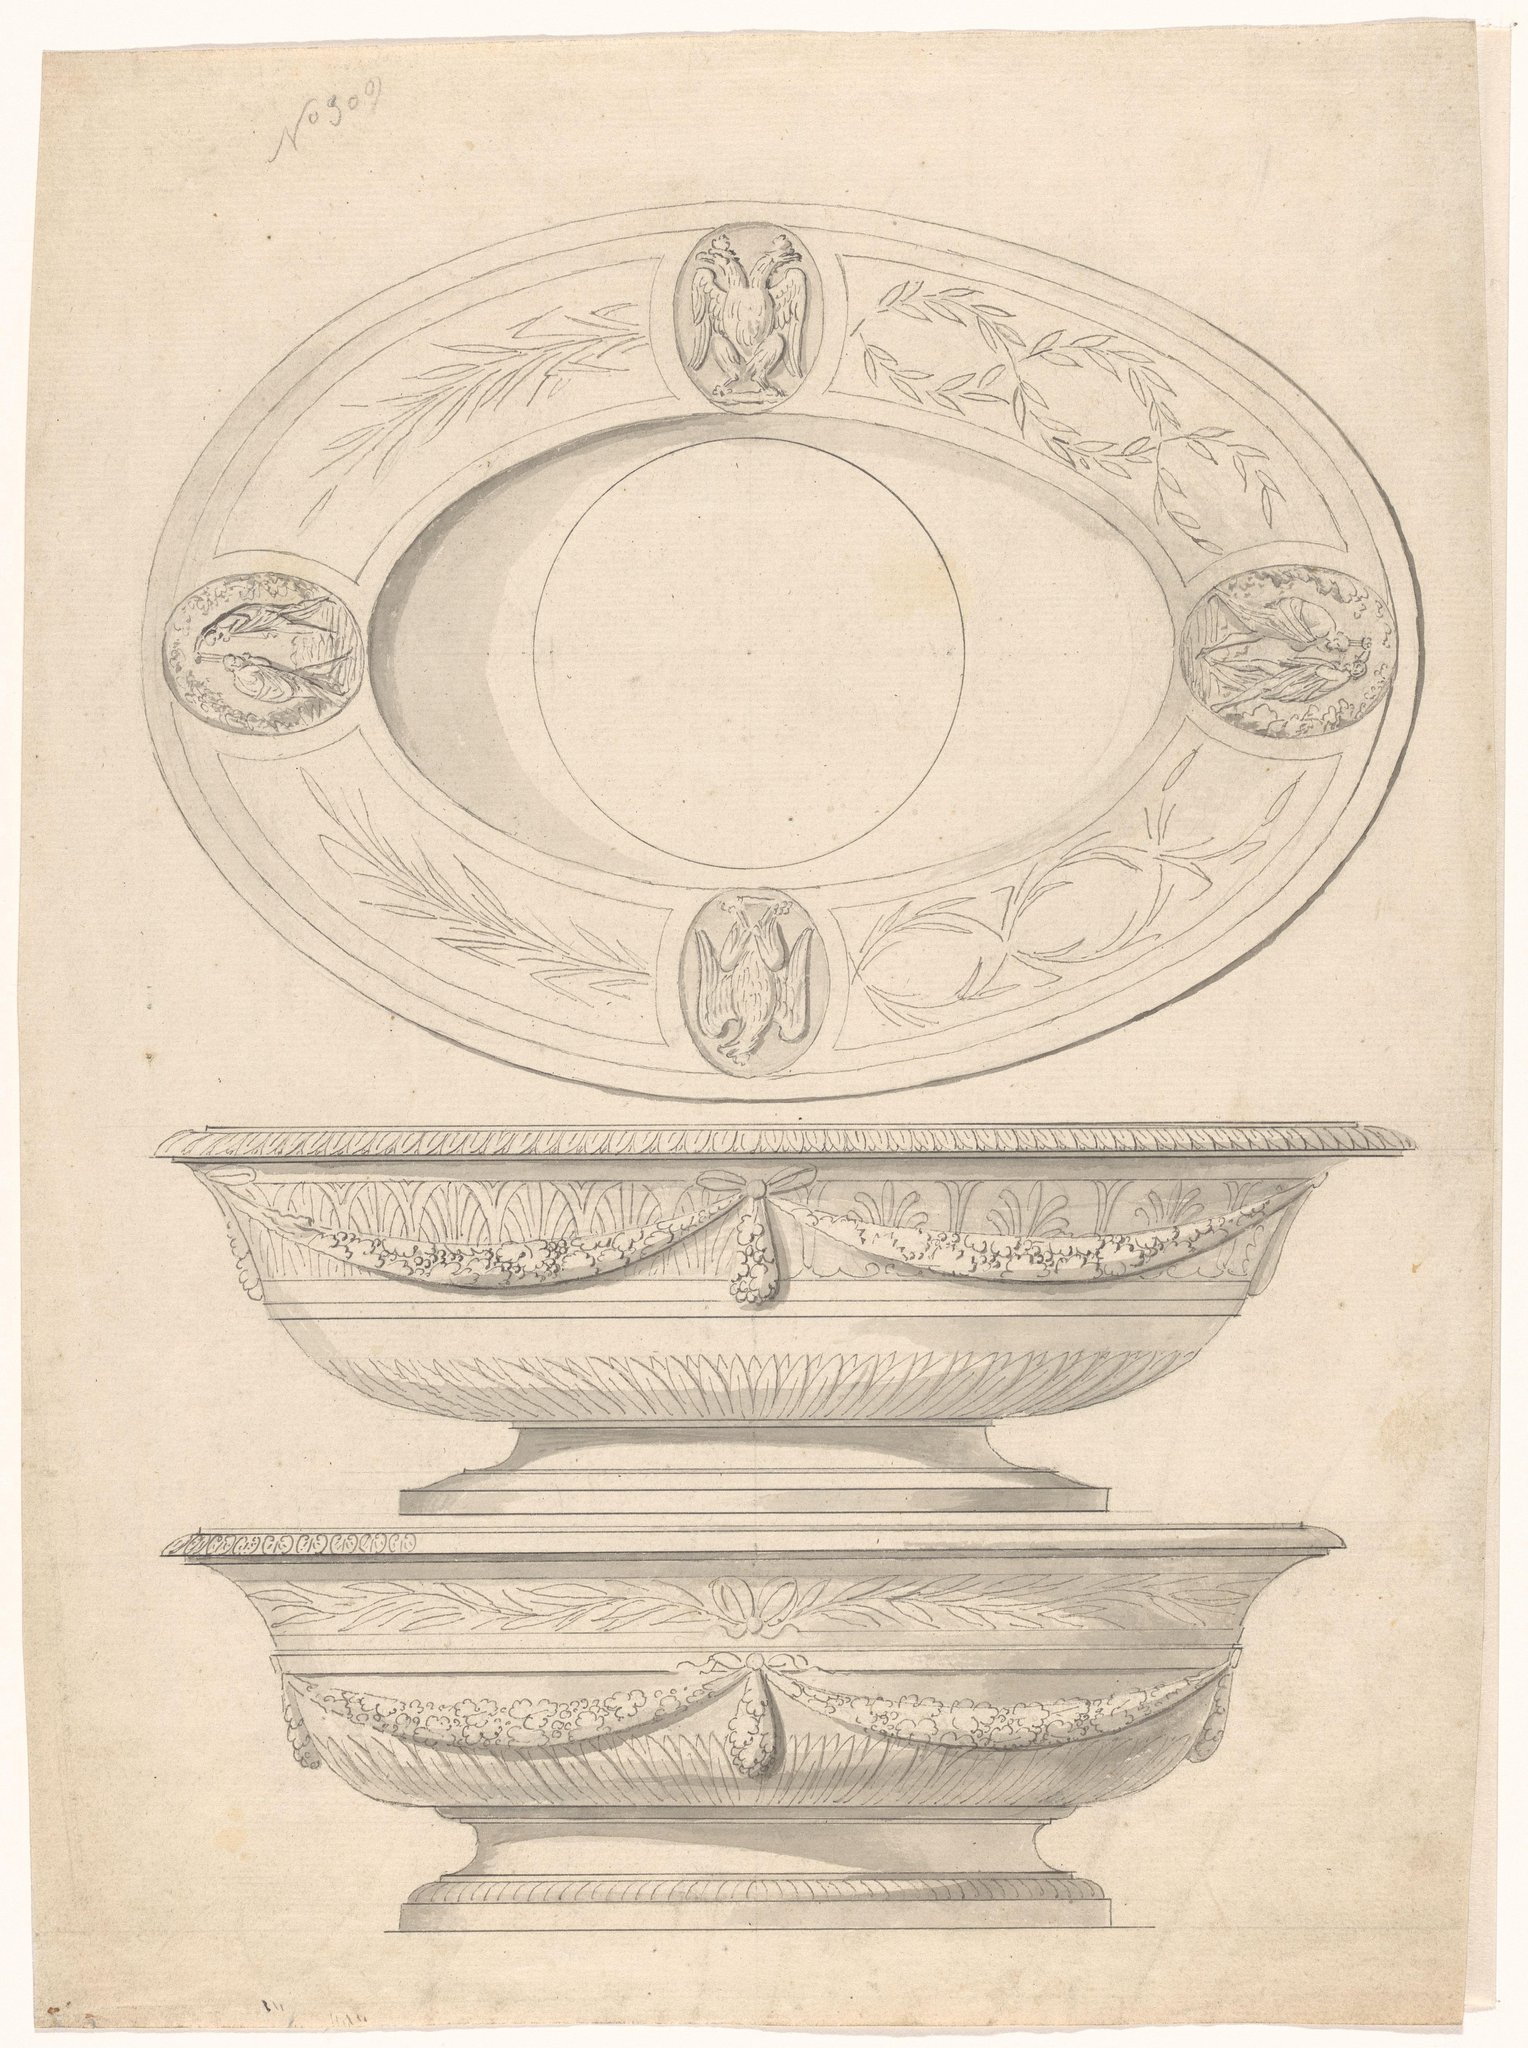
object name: design drawing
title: Ontwerp voor een doopvont, met een bovenaanzicht en twee varianten van een vooraanzicht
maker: Anonymous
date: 1810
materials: graphite, ink, paper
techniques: brush, pen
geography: paris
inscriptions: watermark, number: ‘No 309’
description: De rand vertoont twee doopscènes en een normale en een dubbelkoppige adelaar, vermoedelijk voor keizer Napoleon I en keizerin Marie-Louise. Zie ook RP-T-2019-346.